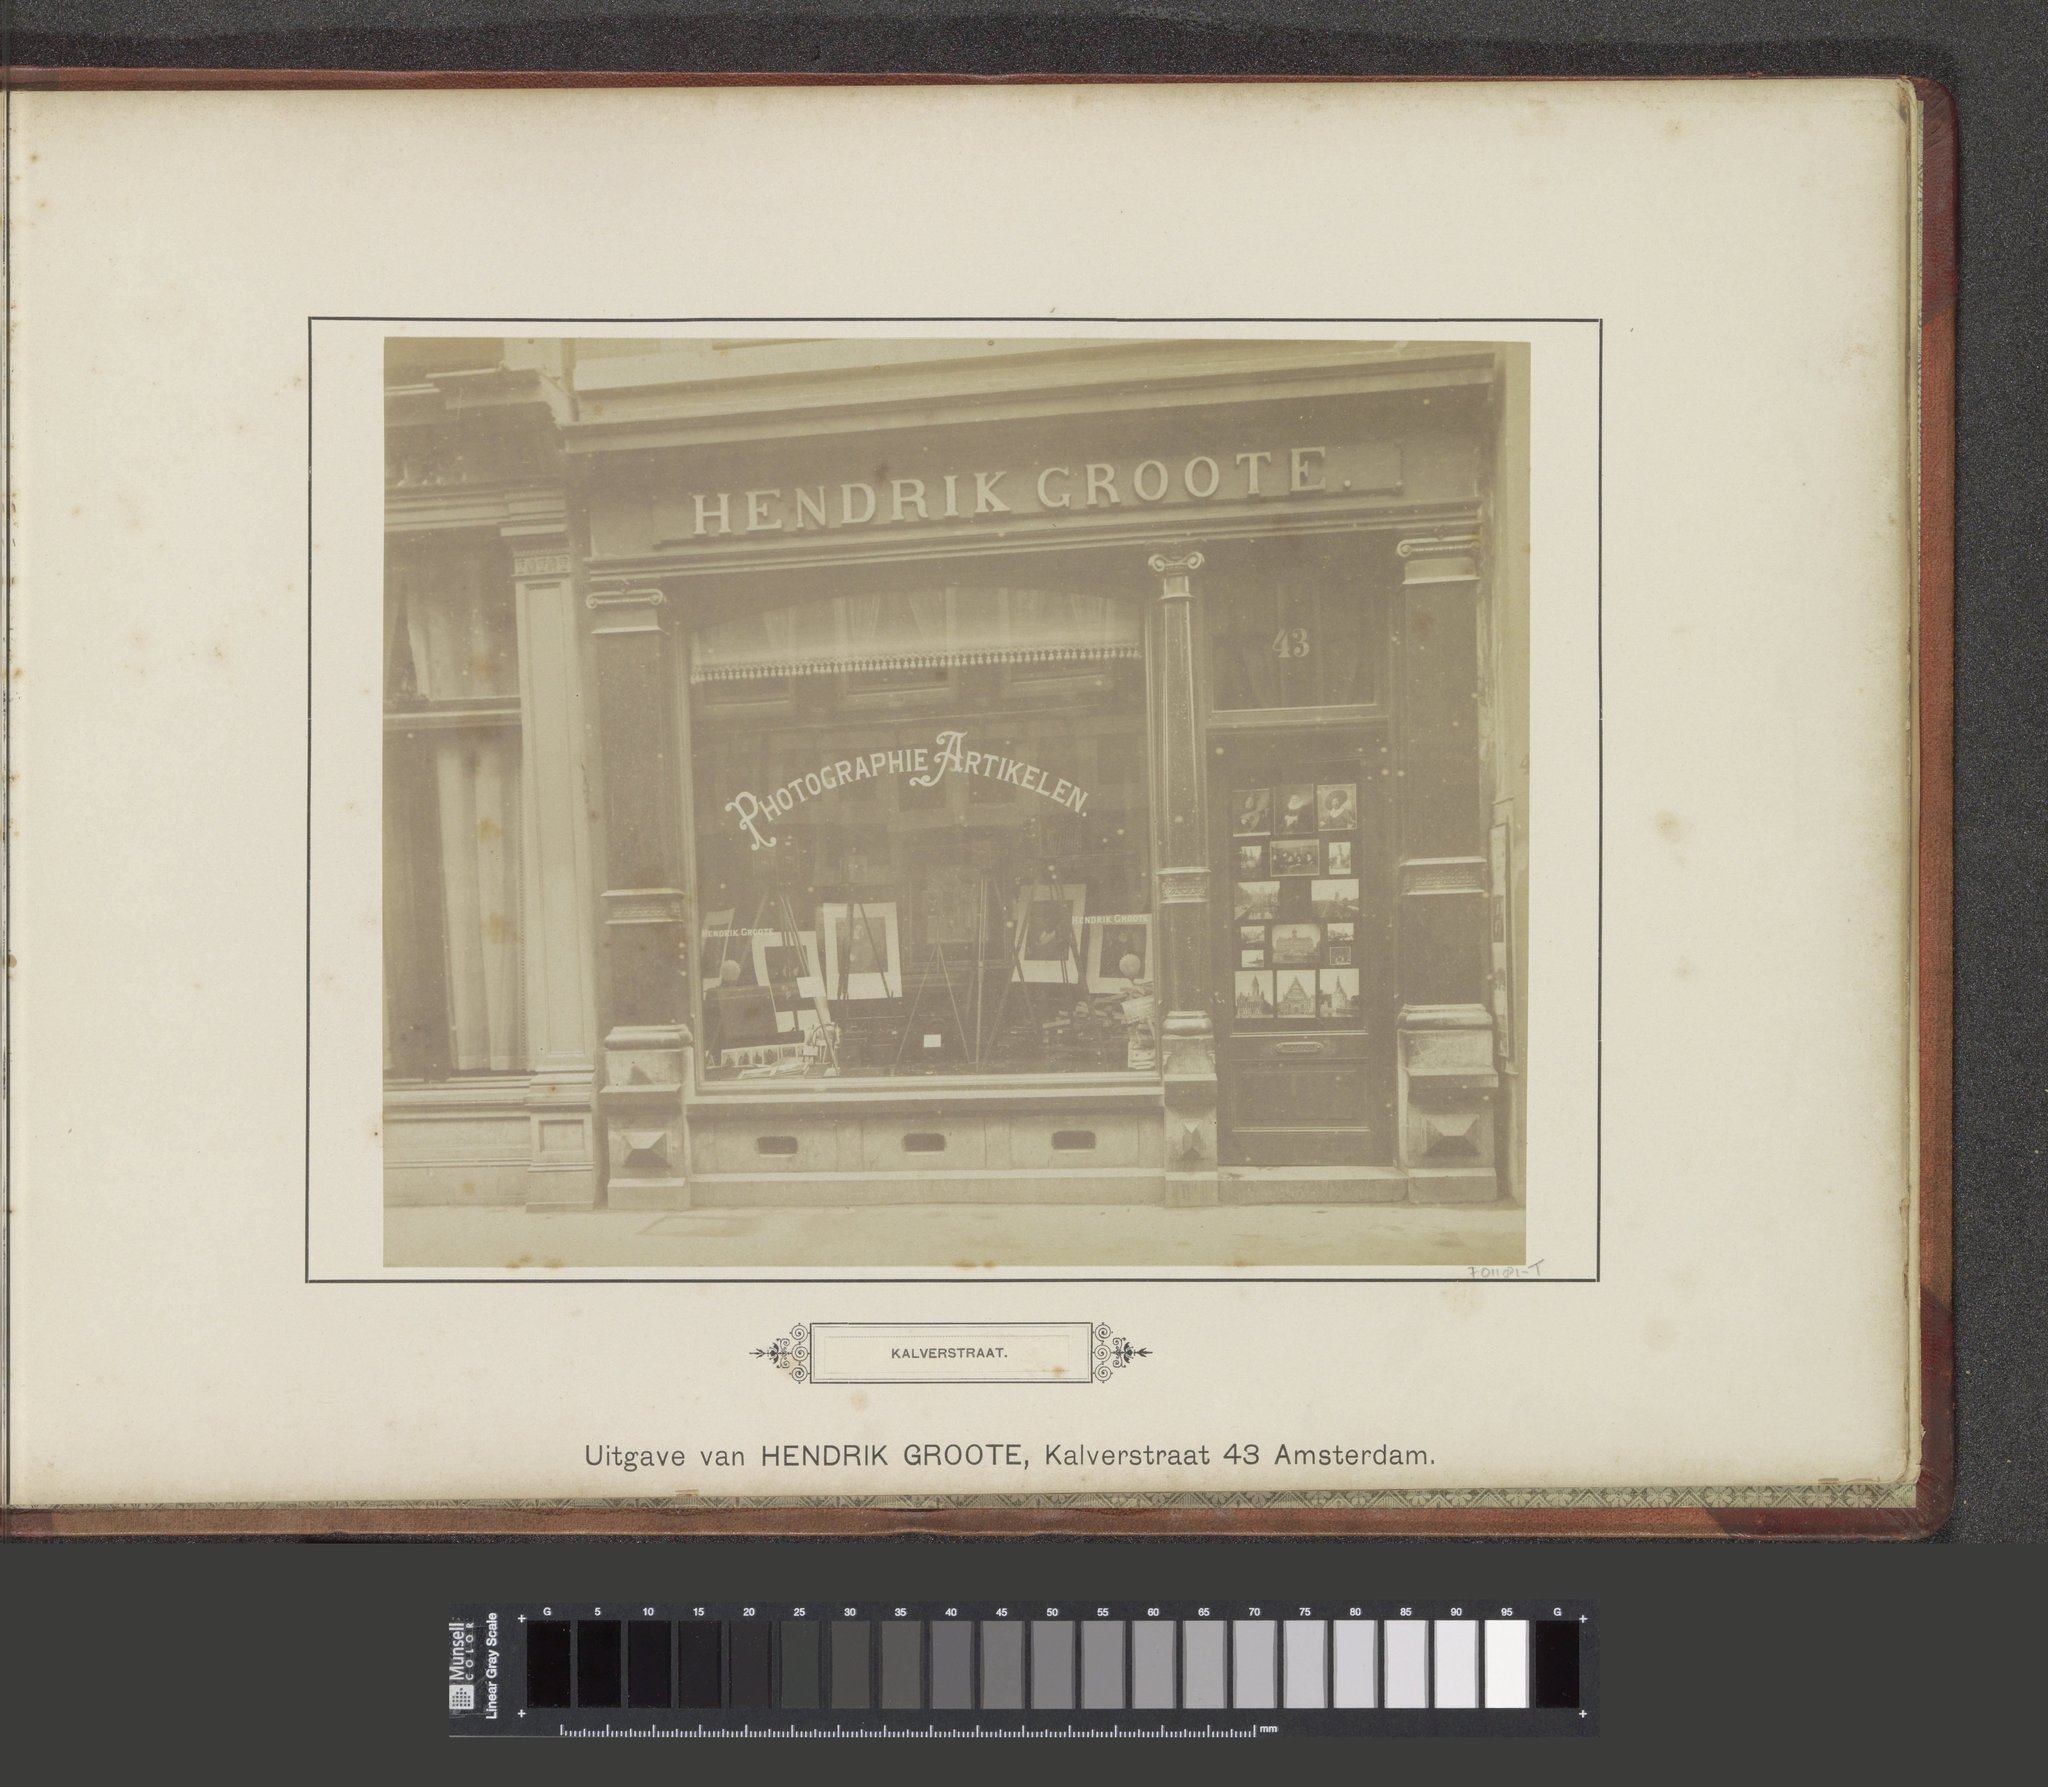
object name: photograph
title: Winkelpui met etalage van Hendrik Groote Photographie Artikelen, in de Kalverstraat te Amsterdam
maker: Anonymous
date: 1895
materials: photographic support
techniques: albumen print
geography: kalverstraat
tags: shop, store, façade (of house or building), closed door, shop-window, show-window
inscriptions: inscription: ‘Hendrik Groote Kalverstraat 43, Amsterdam. Photographic stores. Views from Holland. Photographs from ancient and modern dutch Paintings. Fines ans most complete Collection.’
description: Onderdeel van Fotoalbum met opnames van het centrum van Amsterdam en reclameteksten voor winkels en bedrijven.